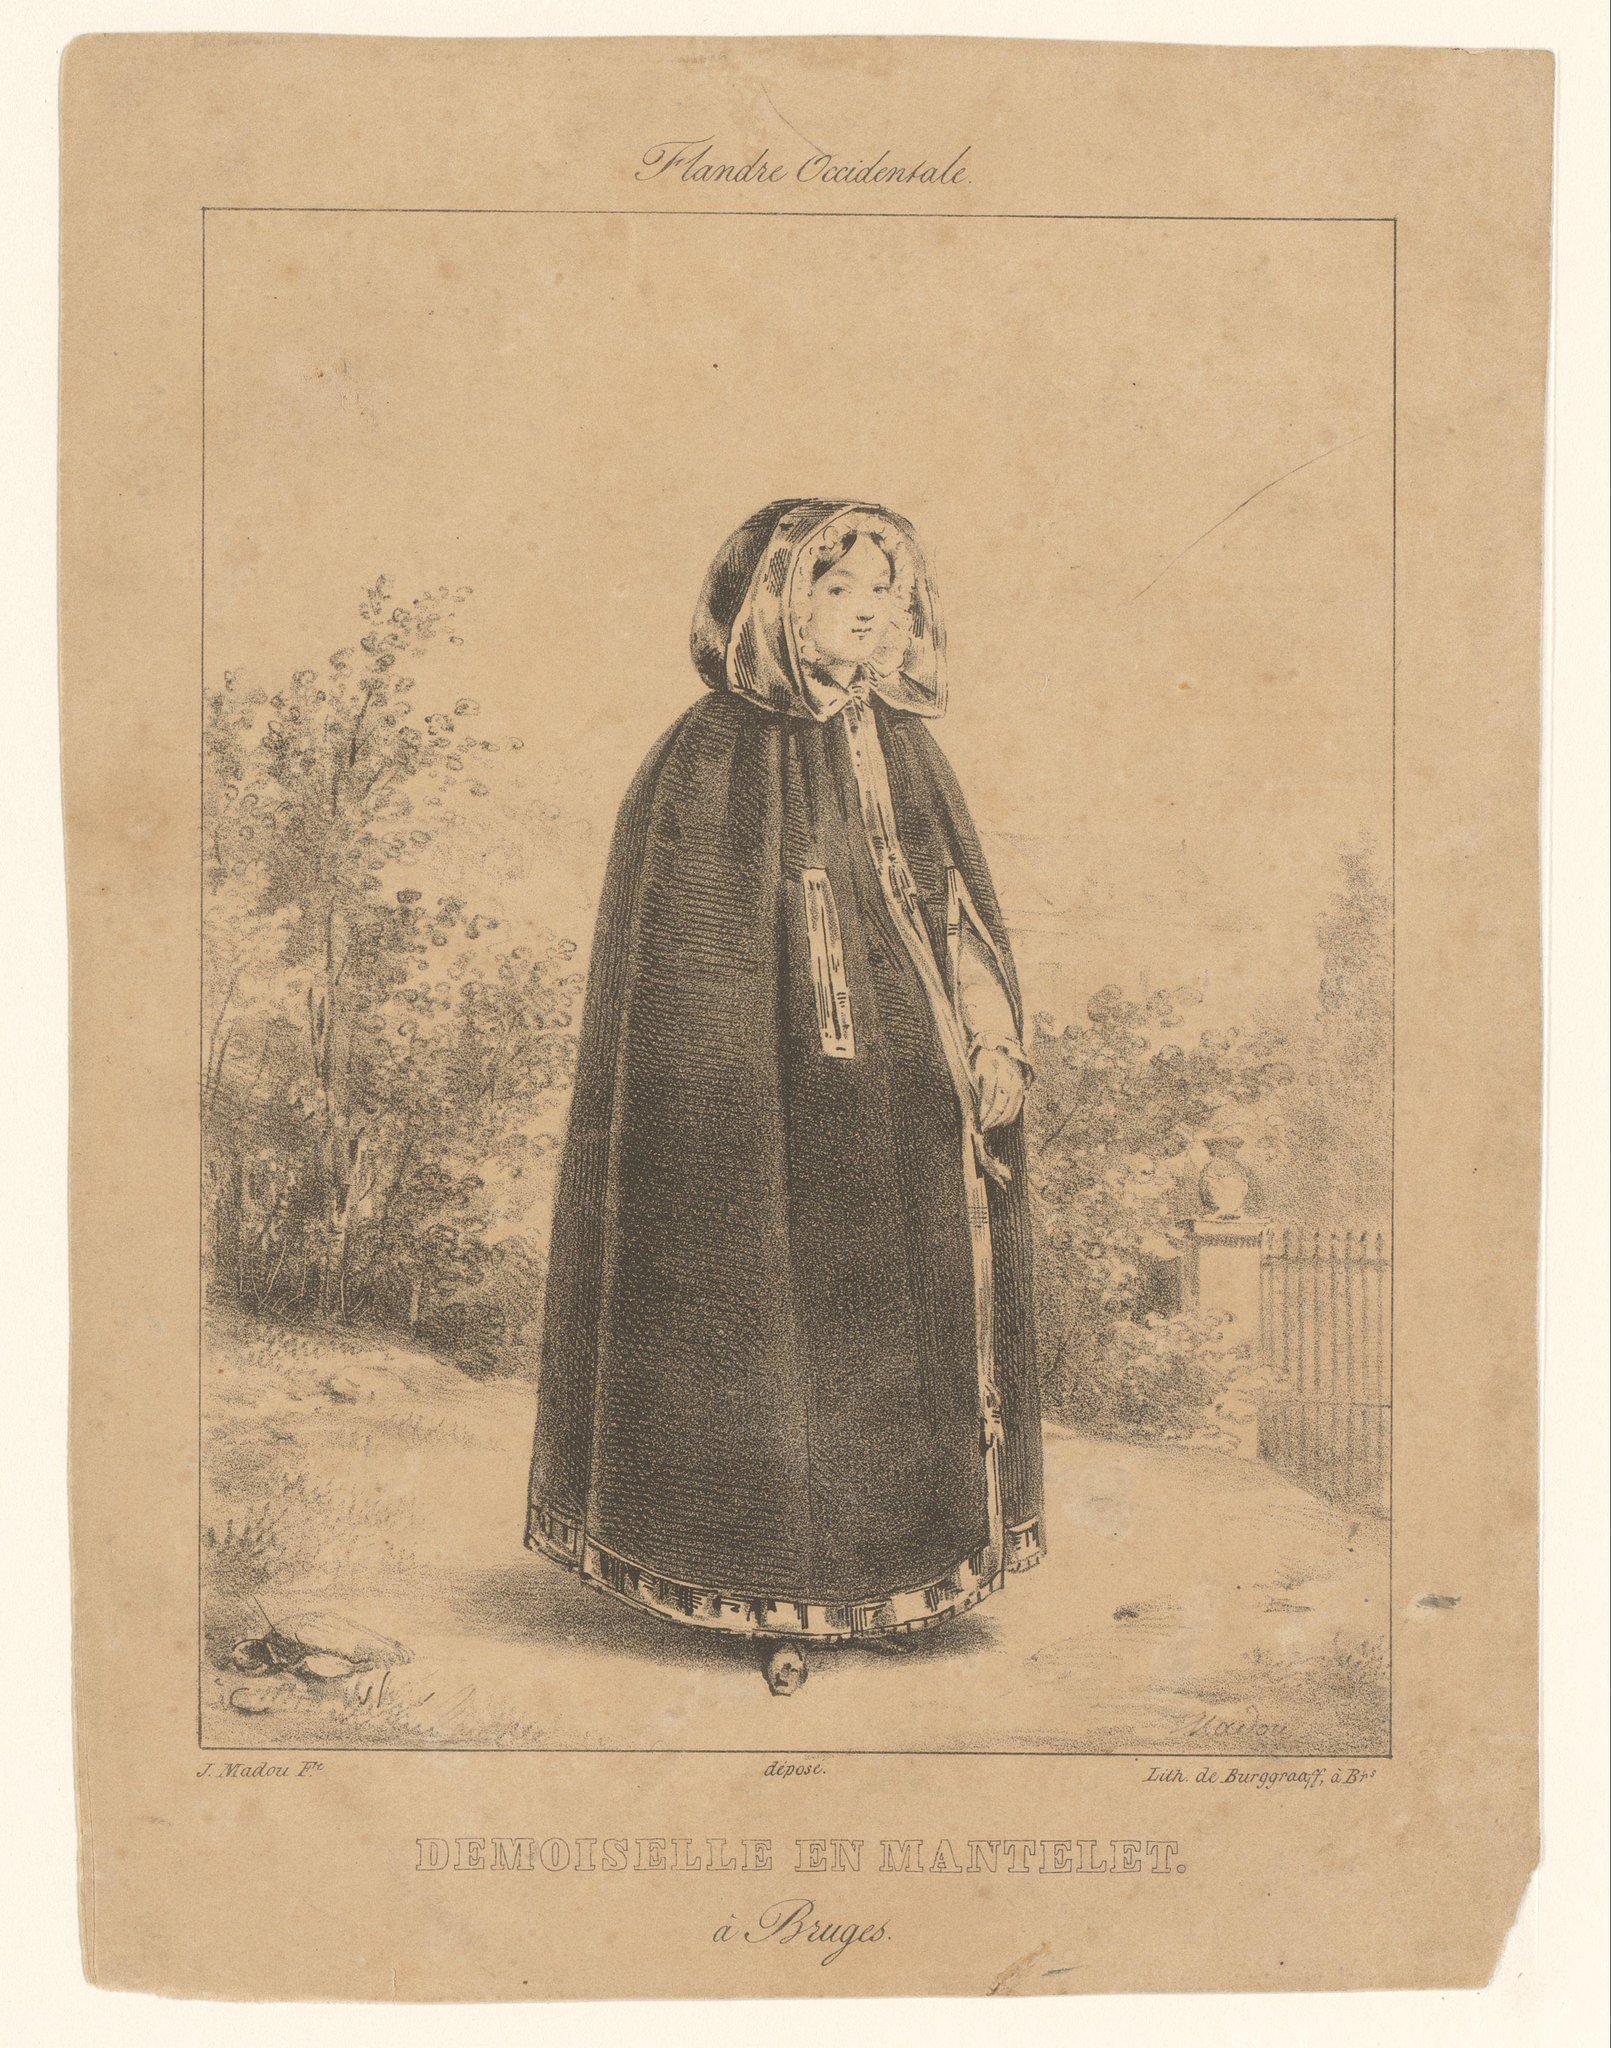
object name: print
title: Collection de costumes du peuple des provinces de la Belgique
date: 1825-1835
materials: paper, pencil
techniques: lithograph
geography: brussels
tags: adolescent, young woman, maiden, folk costume, regional costume, bruges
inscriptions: : ‘Déposé’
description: Van den Burggraaff wilde een serie (twintig afleveringen met telkens vier platen) uitgeven met kostuums uit alle provincies van Nederland en België onder de titel 'Costumes du peuple de toutes les provinces des Pays-Bas'. Hij begint met deze serie in 1825 en eindigt hiermee bij de dertiende aflevering in 1830. Omdat in 1830 België zicht afsplitst van Nederland geeft hij de prenten daarna apart uit onder de titels 'Costumes de peuple Hollandais' en 'Collection de costumes du peuple des provinces de la Belgique' (1835).